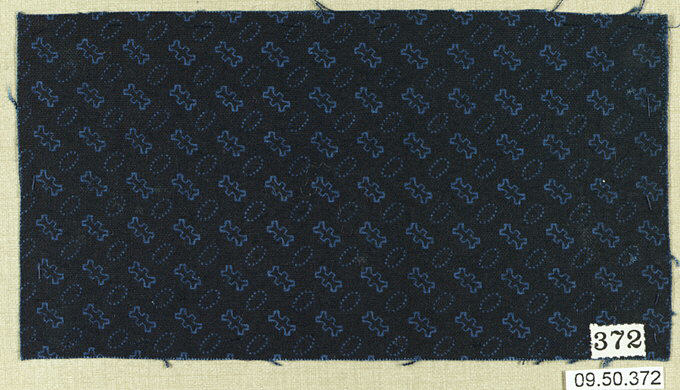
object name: piece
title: Piece (one of 116)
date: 1801-1900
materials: cotton